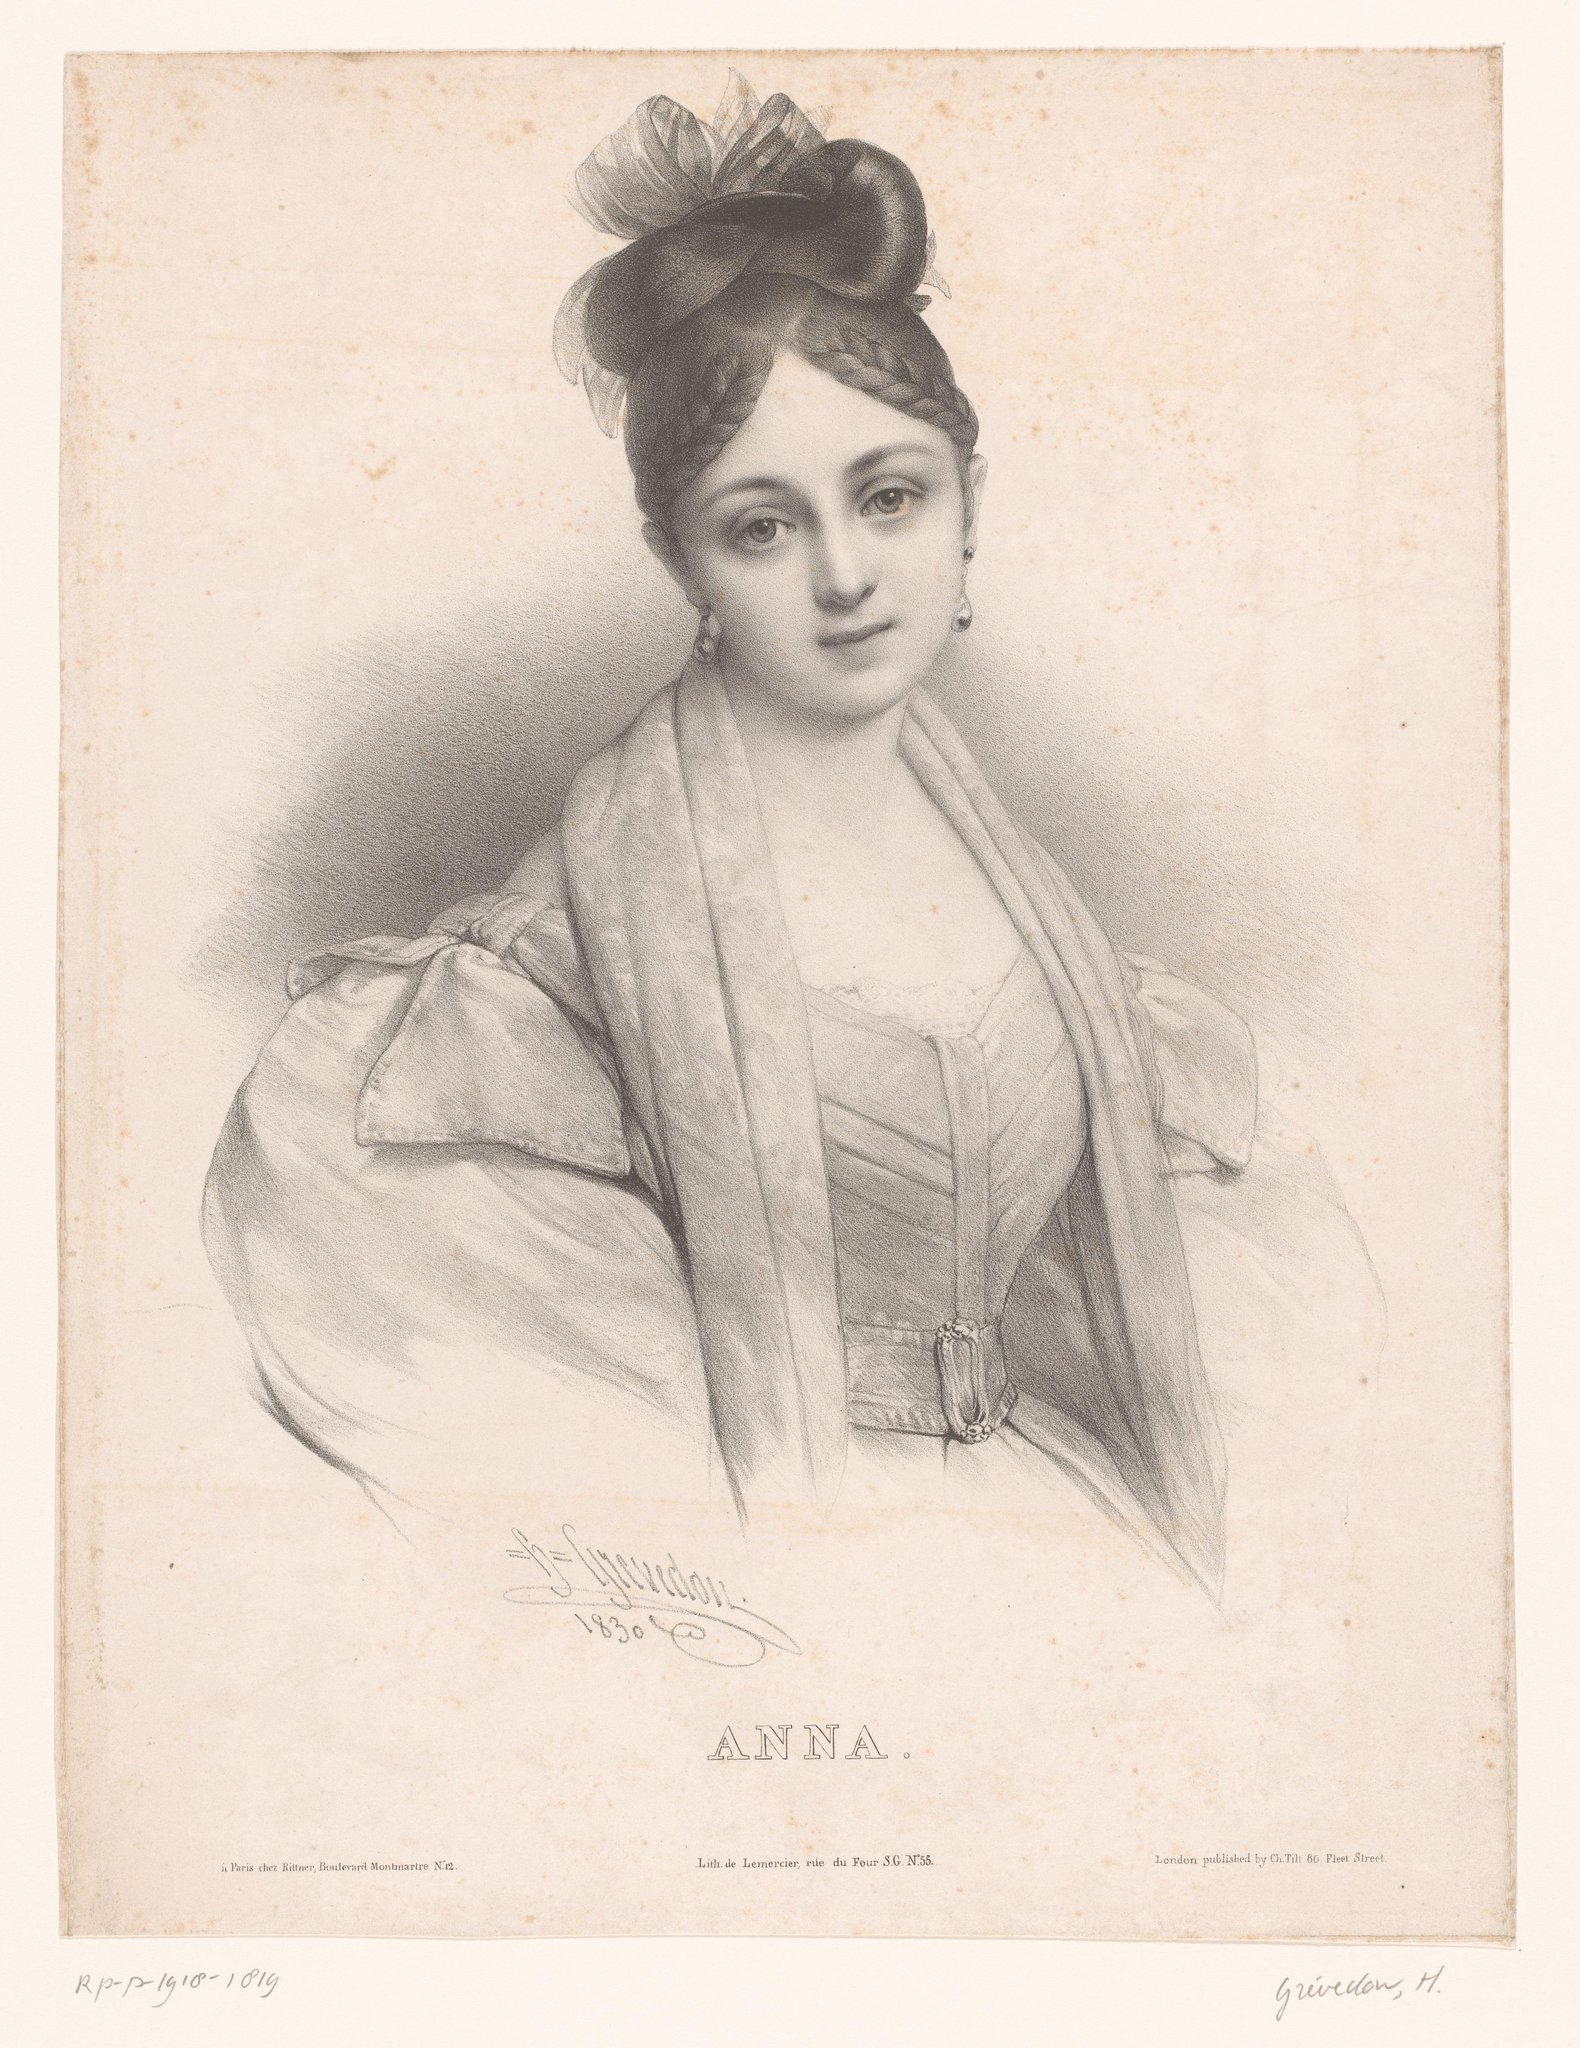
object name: print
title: Dames met namen volgens het alfabet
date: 1830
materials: paper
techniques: lithograph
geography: london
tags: adolescent, young woman, maiden, letters, alphabet, script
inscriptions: collector's mark: Lugt 2233